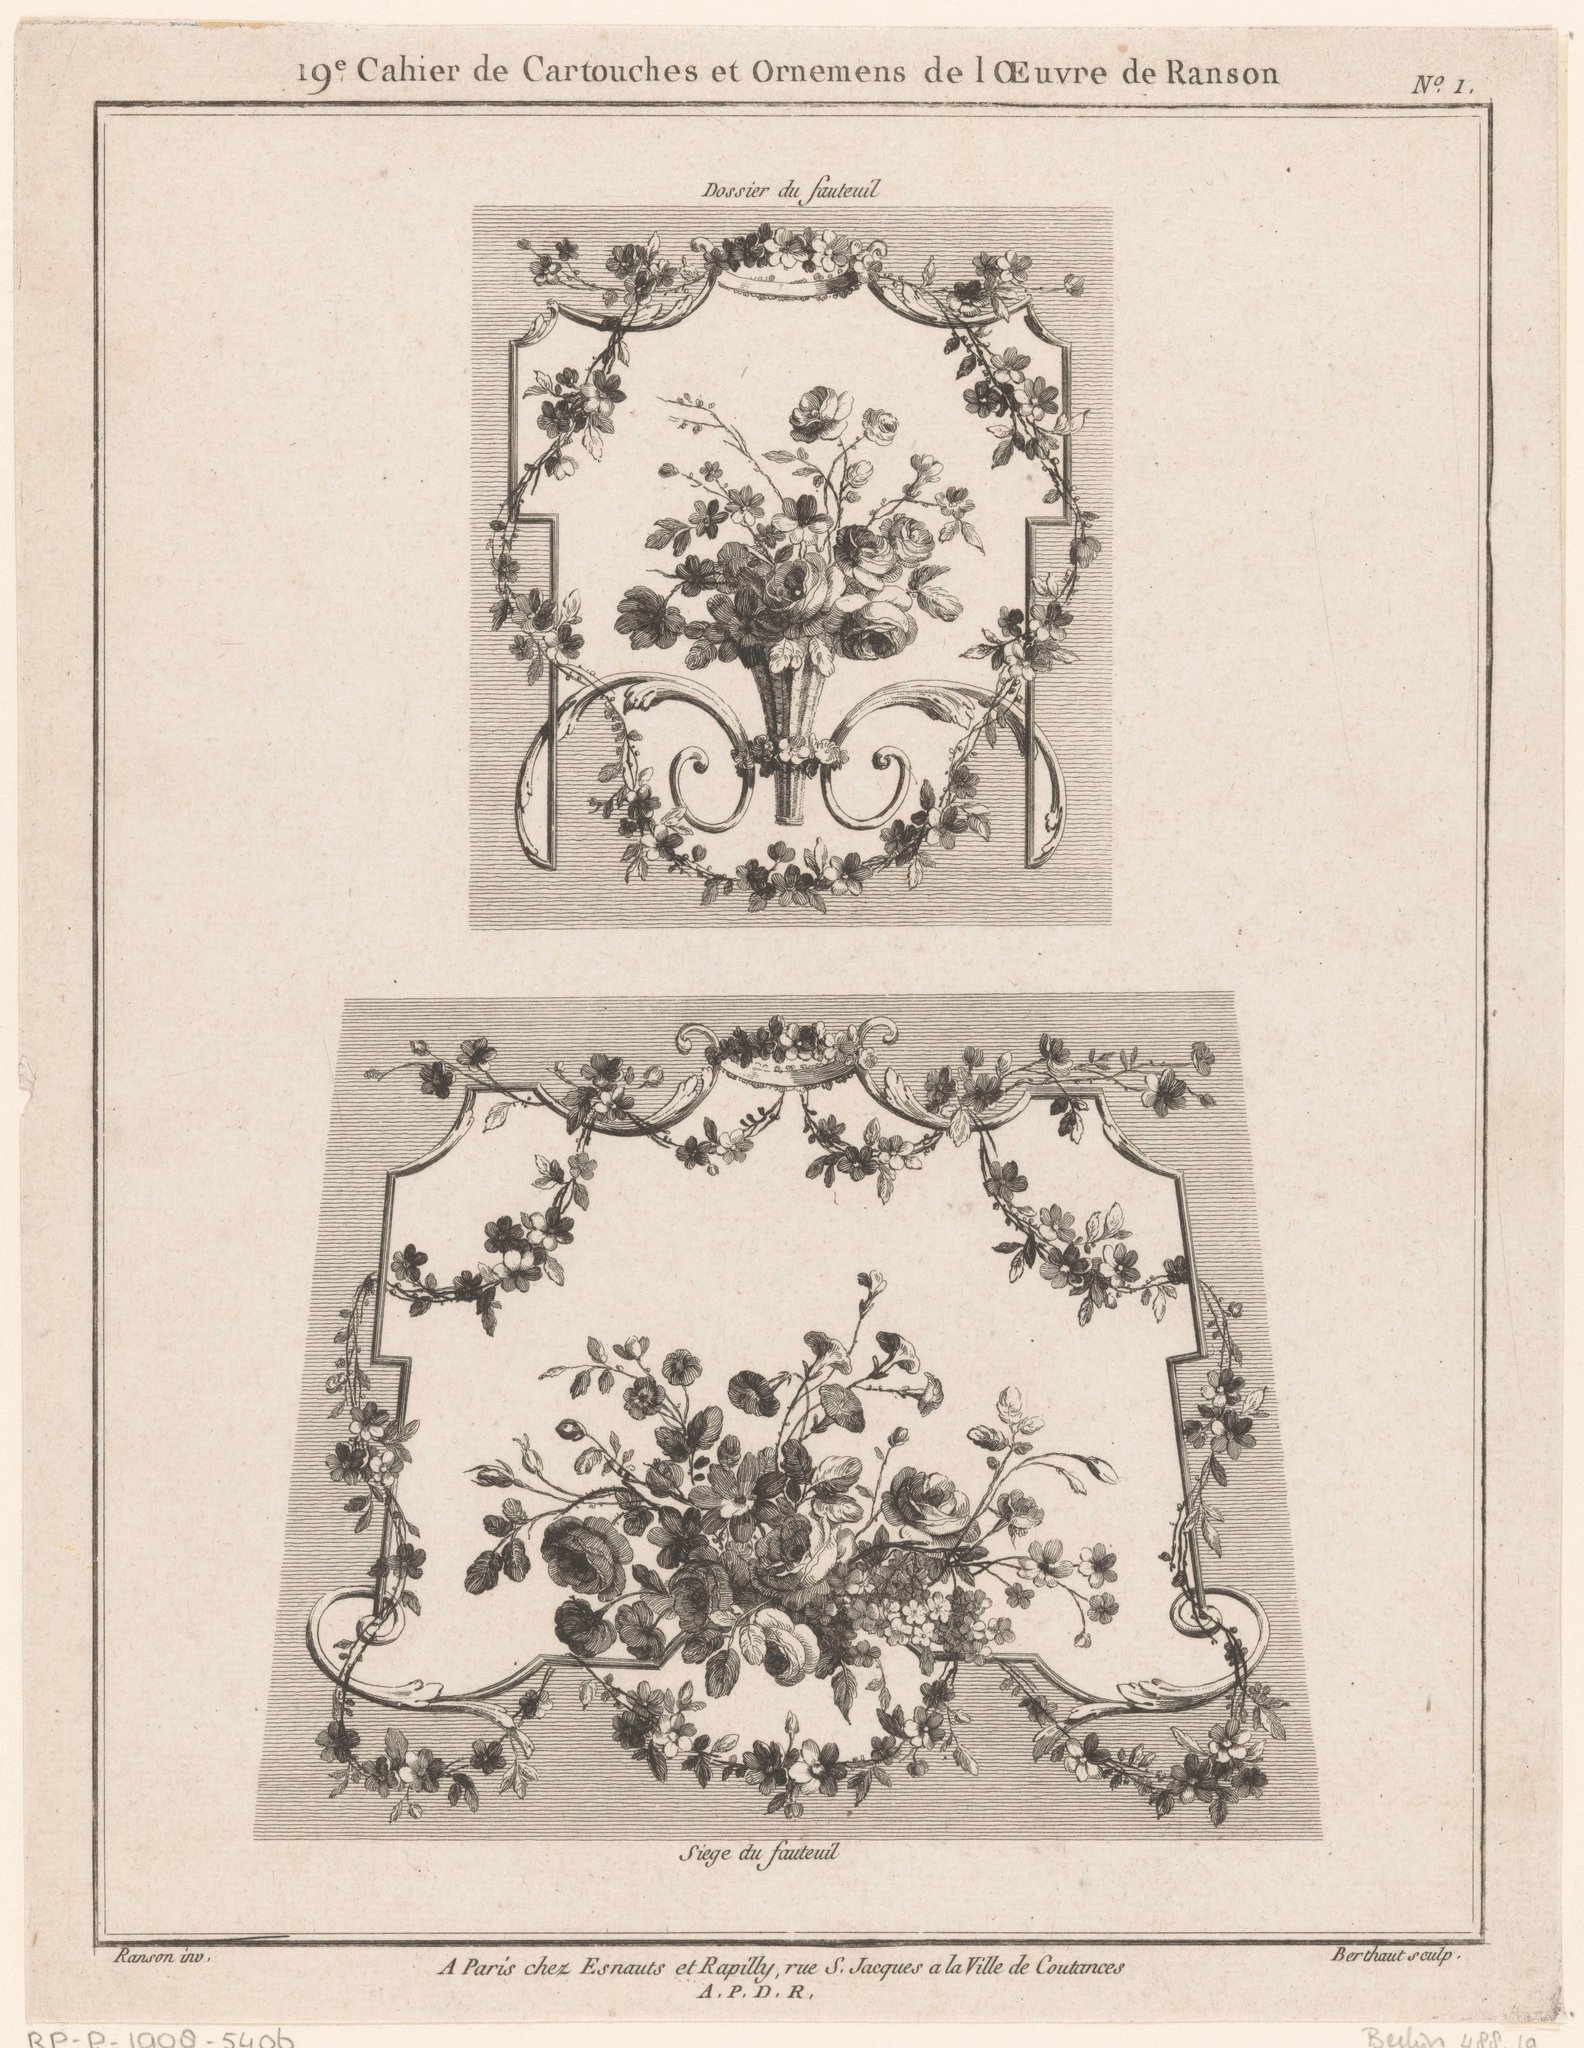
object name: titelprent, frontispice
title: Stoelbekleding met vaas en bloemen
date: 1778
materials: paper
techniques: etching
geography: paris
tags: vase ~ ornament, chair, flowers ~ ornament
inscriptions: collector's mark: Lugt 2228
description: Rug- en zitbekleding met een omlijsting van bloemen. Op de rugbekleding een vaas met bloemen. Op de zitbekleding diverse bloemen.